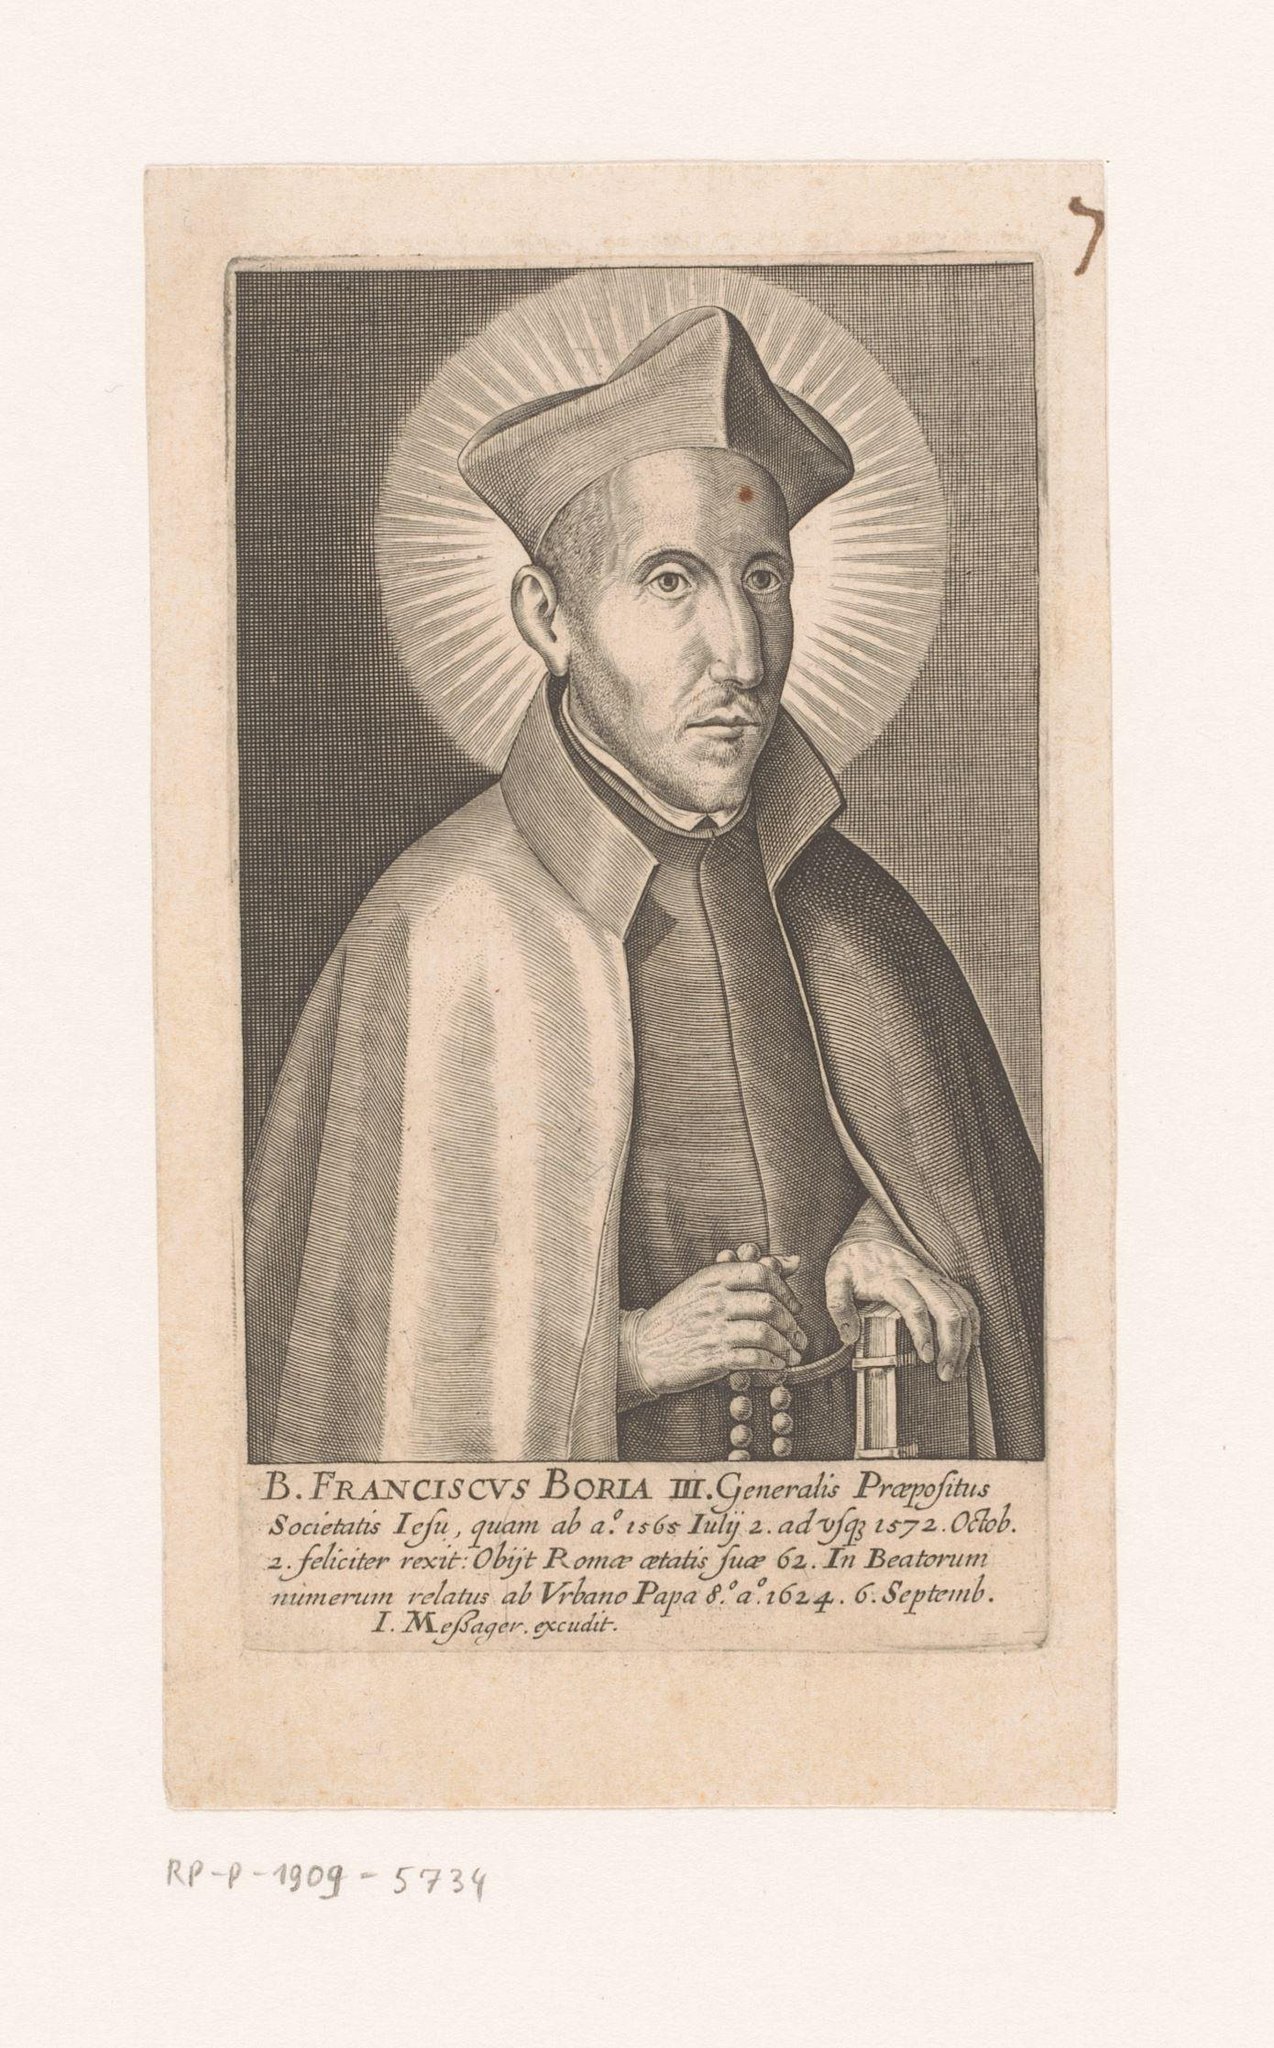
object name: print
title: Portret van Franciscus Borgia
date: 1590-1649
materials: paper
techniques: engraving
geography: paris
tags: clergyman, historical persons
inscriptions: number: ‘7’, collector's mark: Lugt 2228